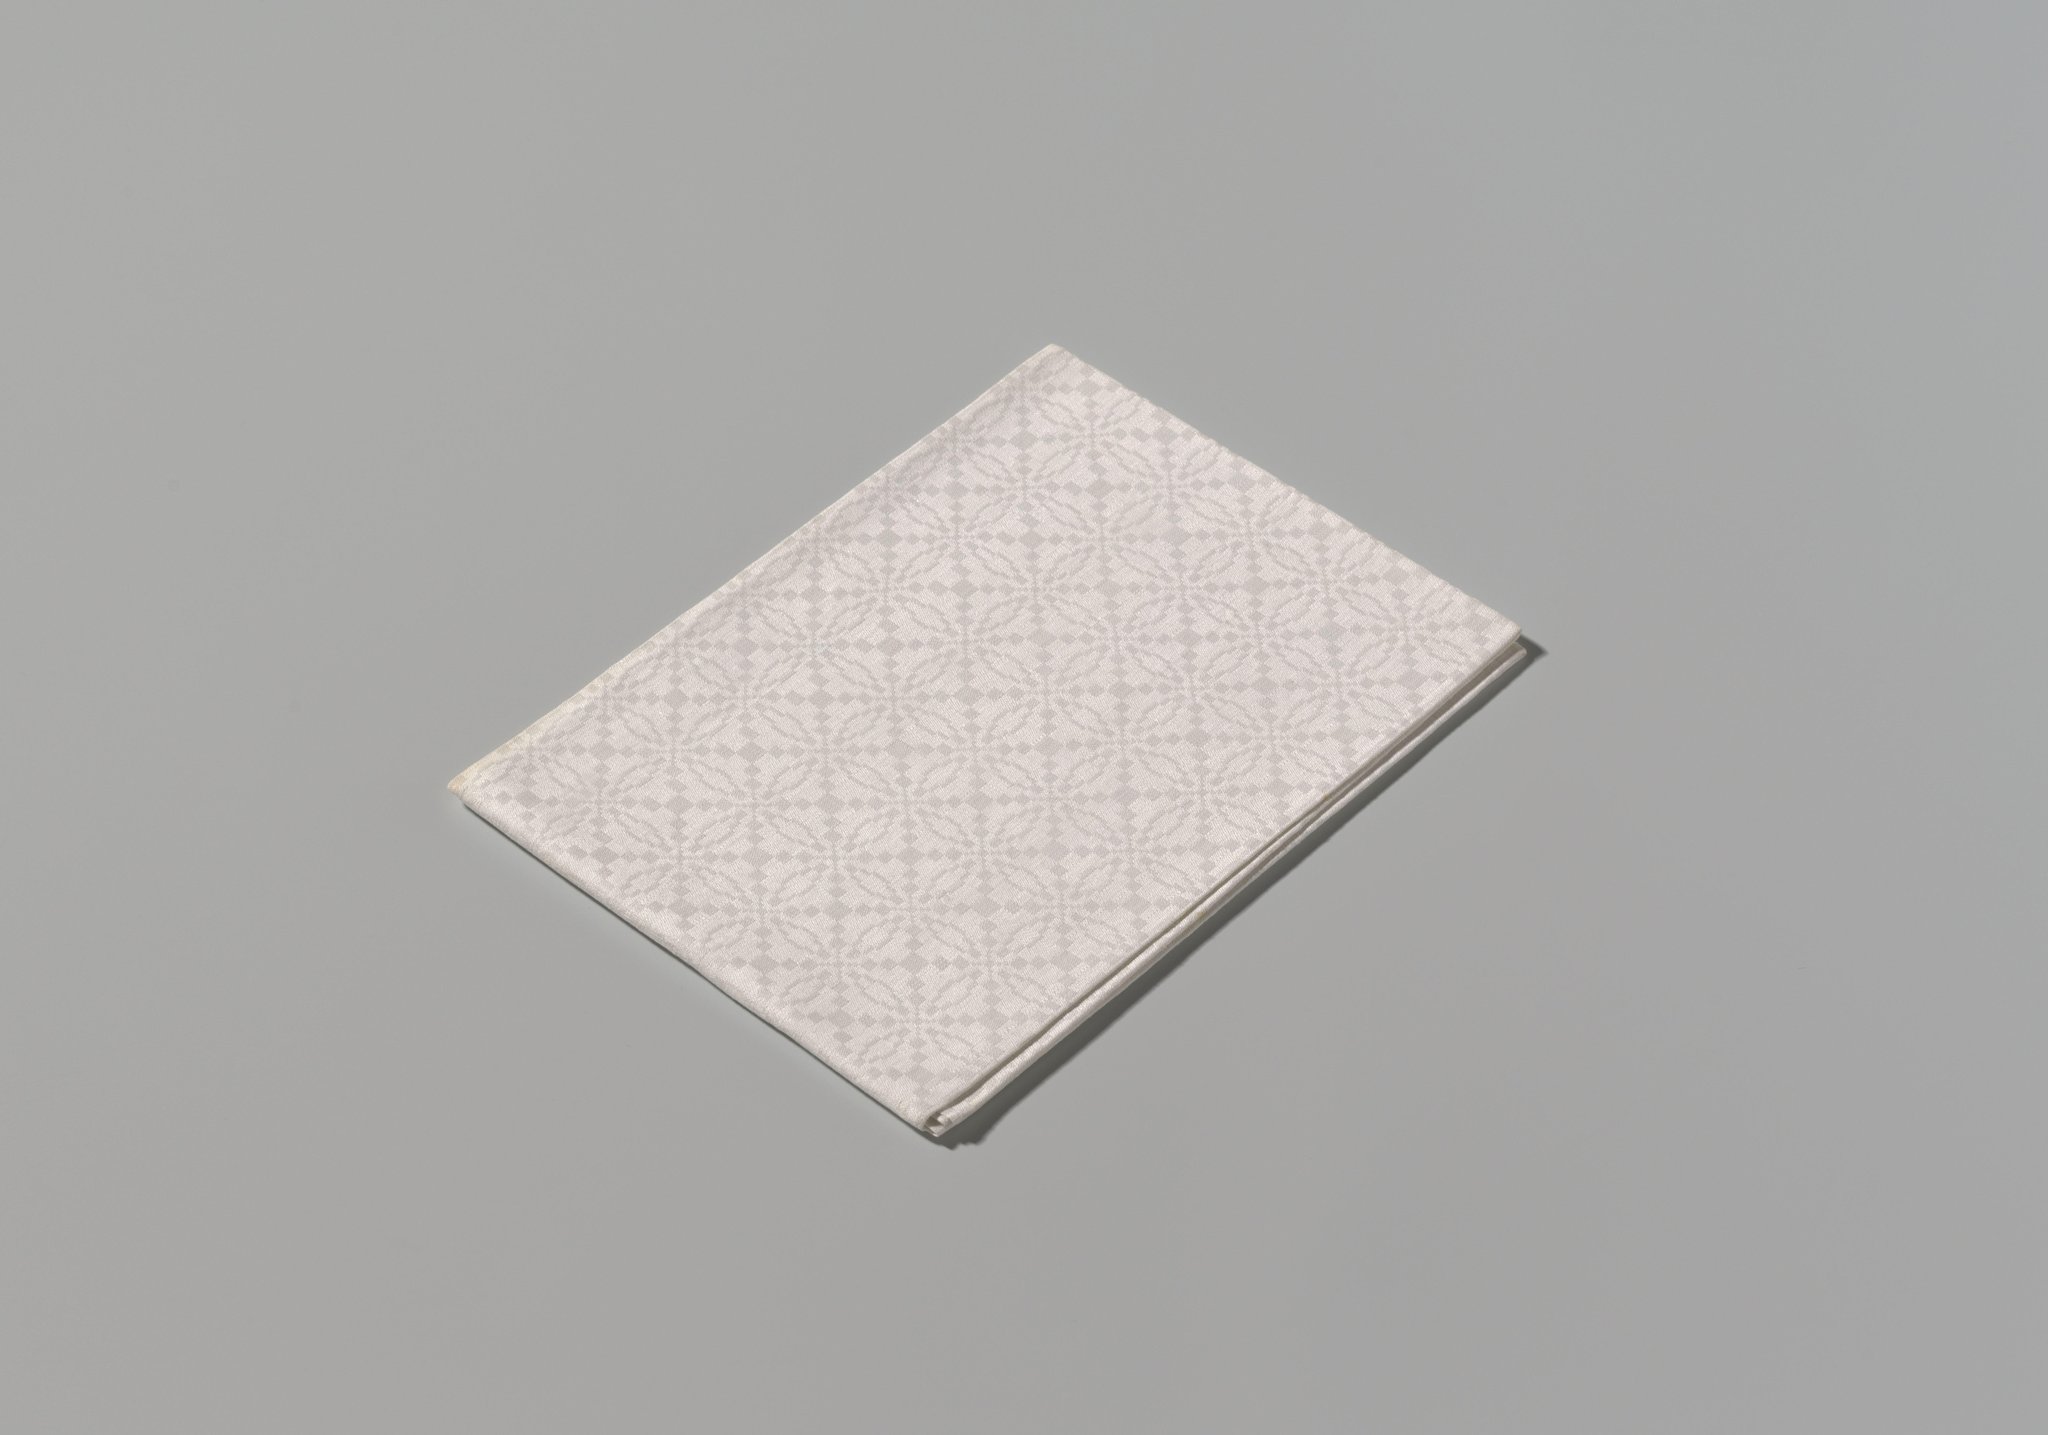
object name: napkin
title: Wit linnen pellen servet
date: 1600-1650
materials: linen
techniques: peeled fabric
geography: northern netherlands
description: Wit linnen pellen servet, gemerkt WO 70.